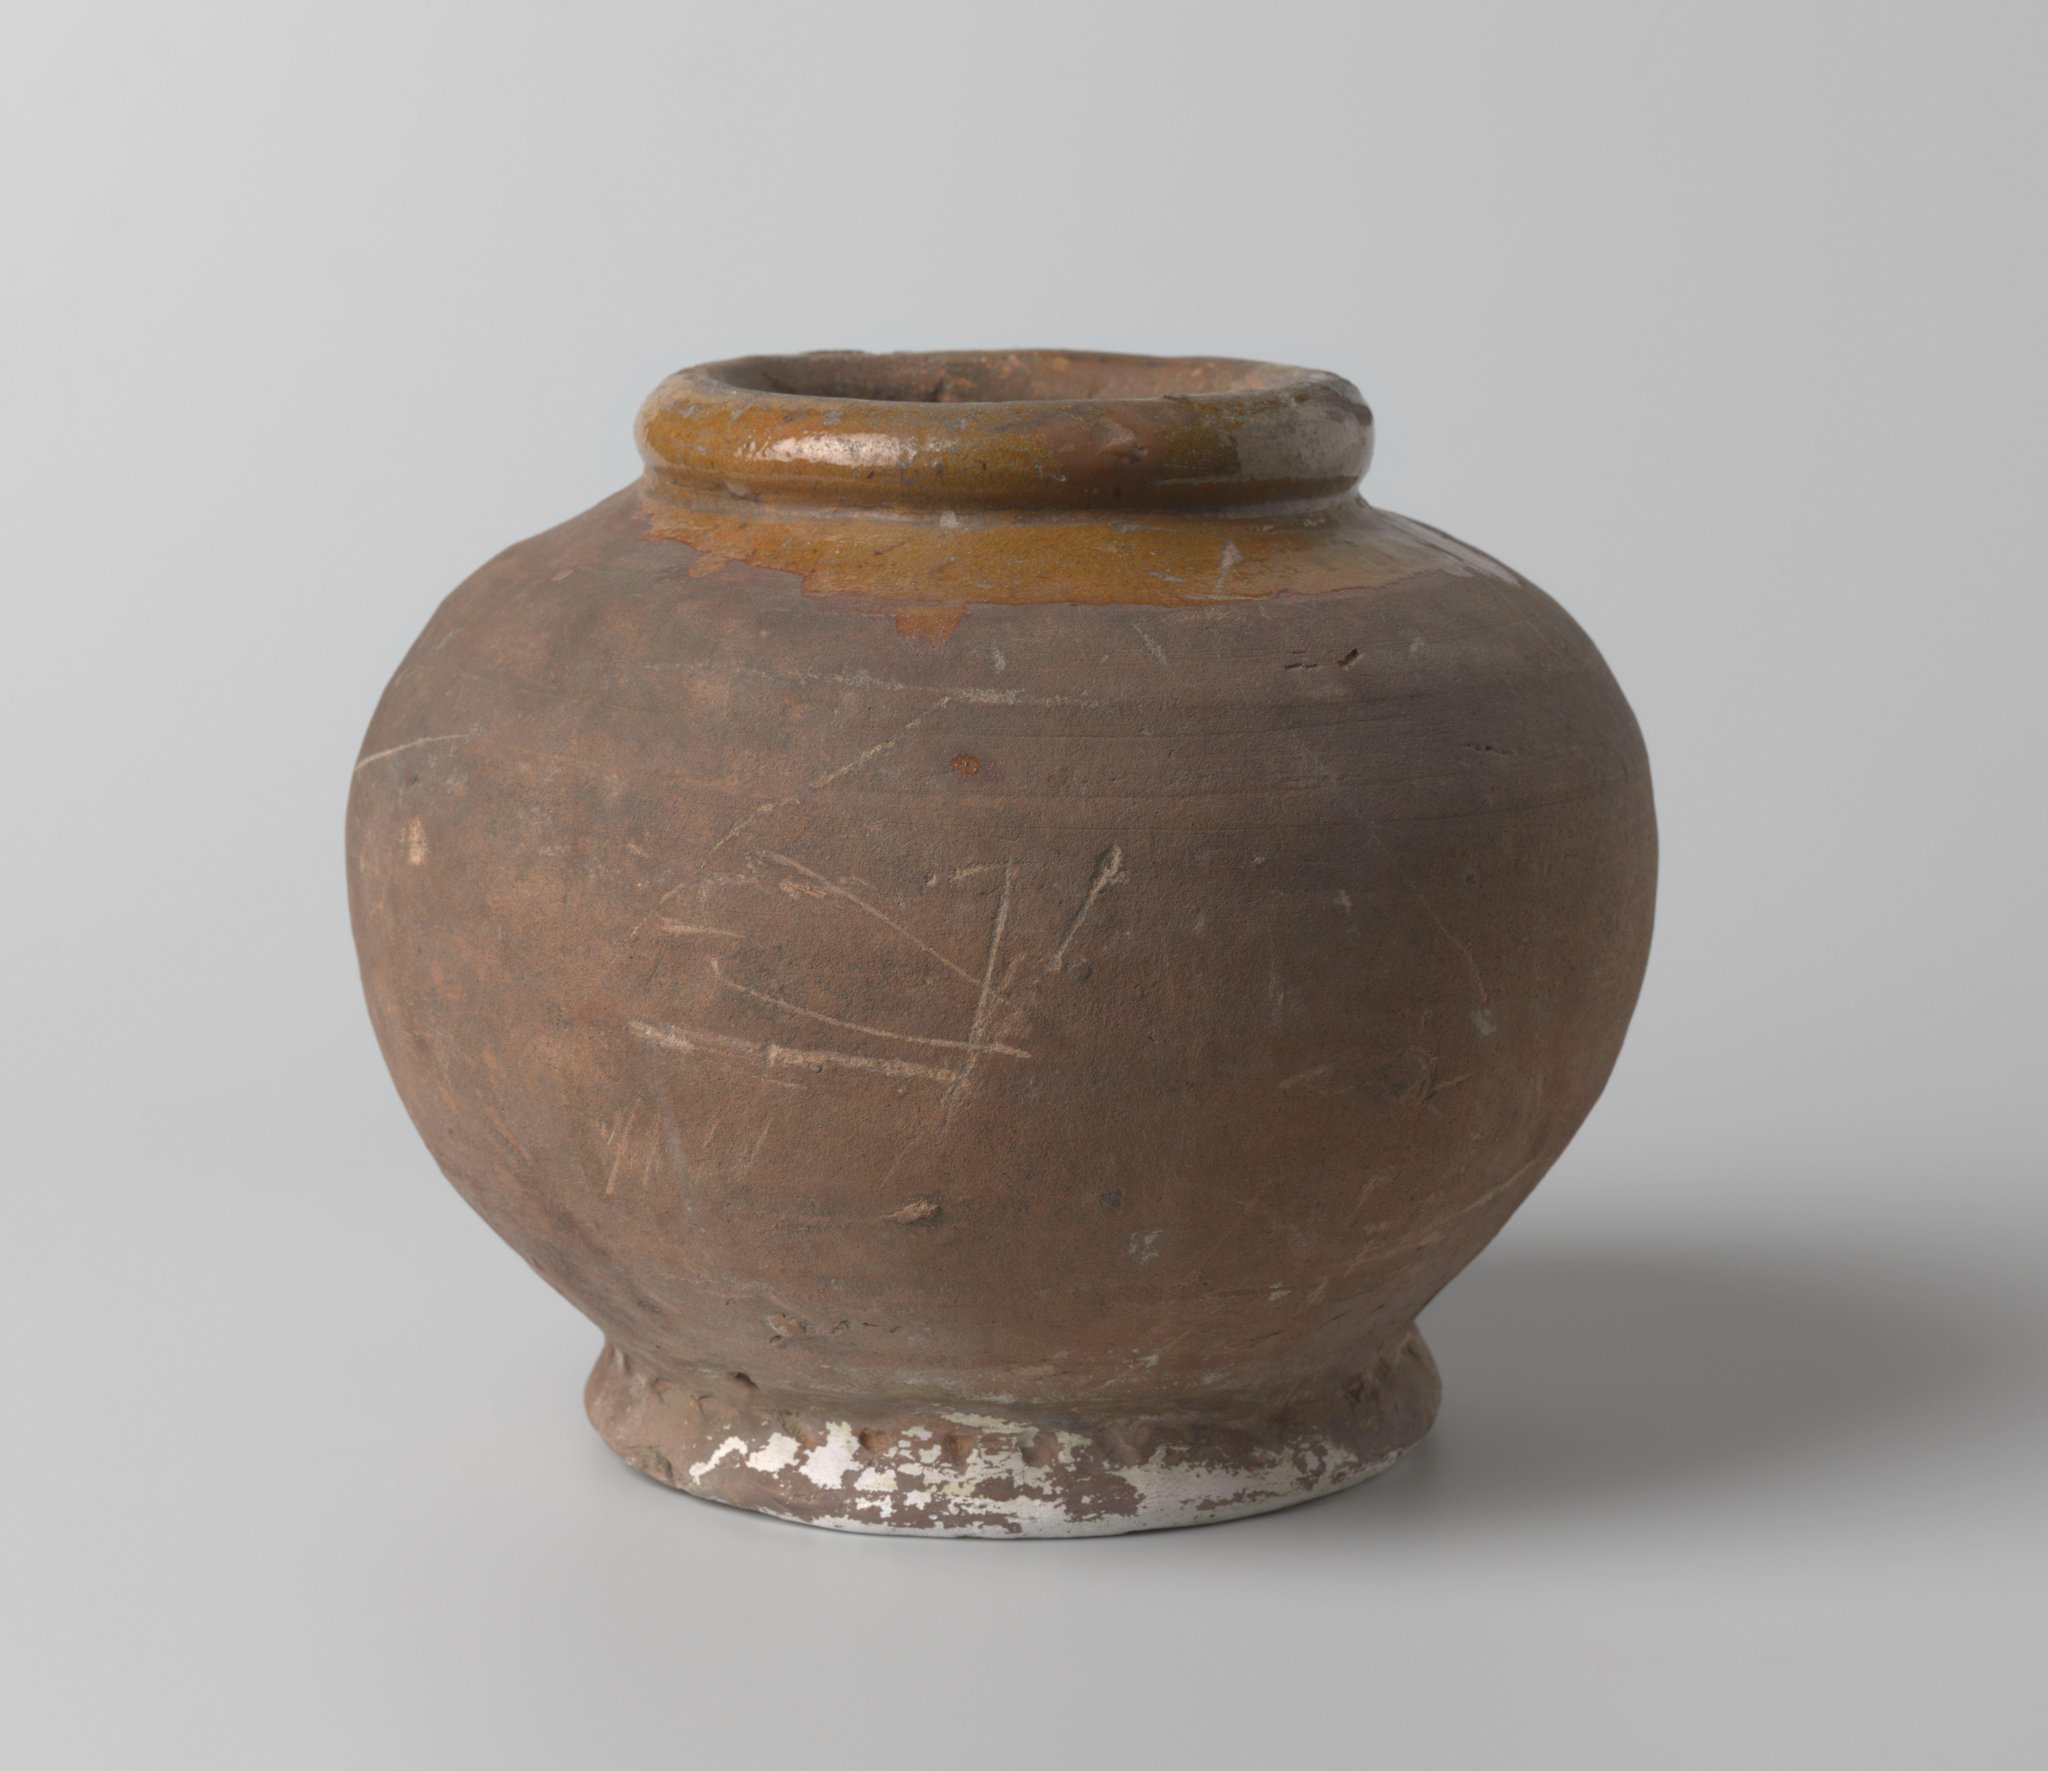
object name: pot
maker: Anonymous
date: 1400-1950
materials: earthenware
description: Pot van aardewerk, geglazuurd aan de binnenzijde en aan de buitenzijde gedeeltelijk langs de mond en -rand.